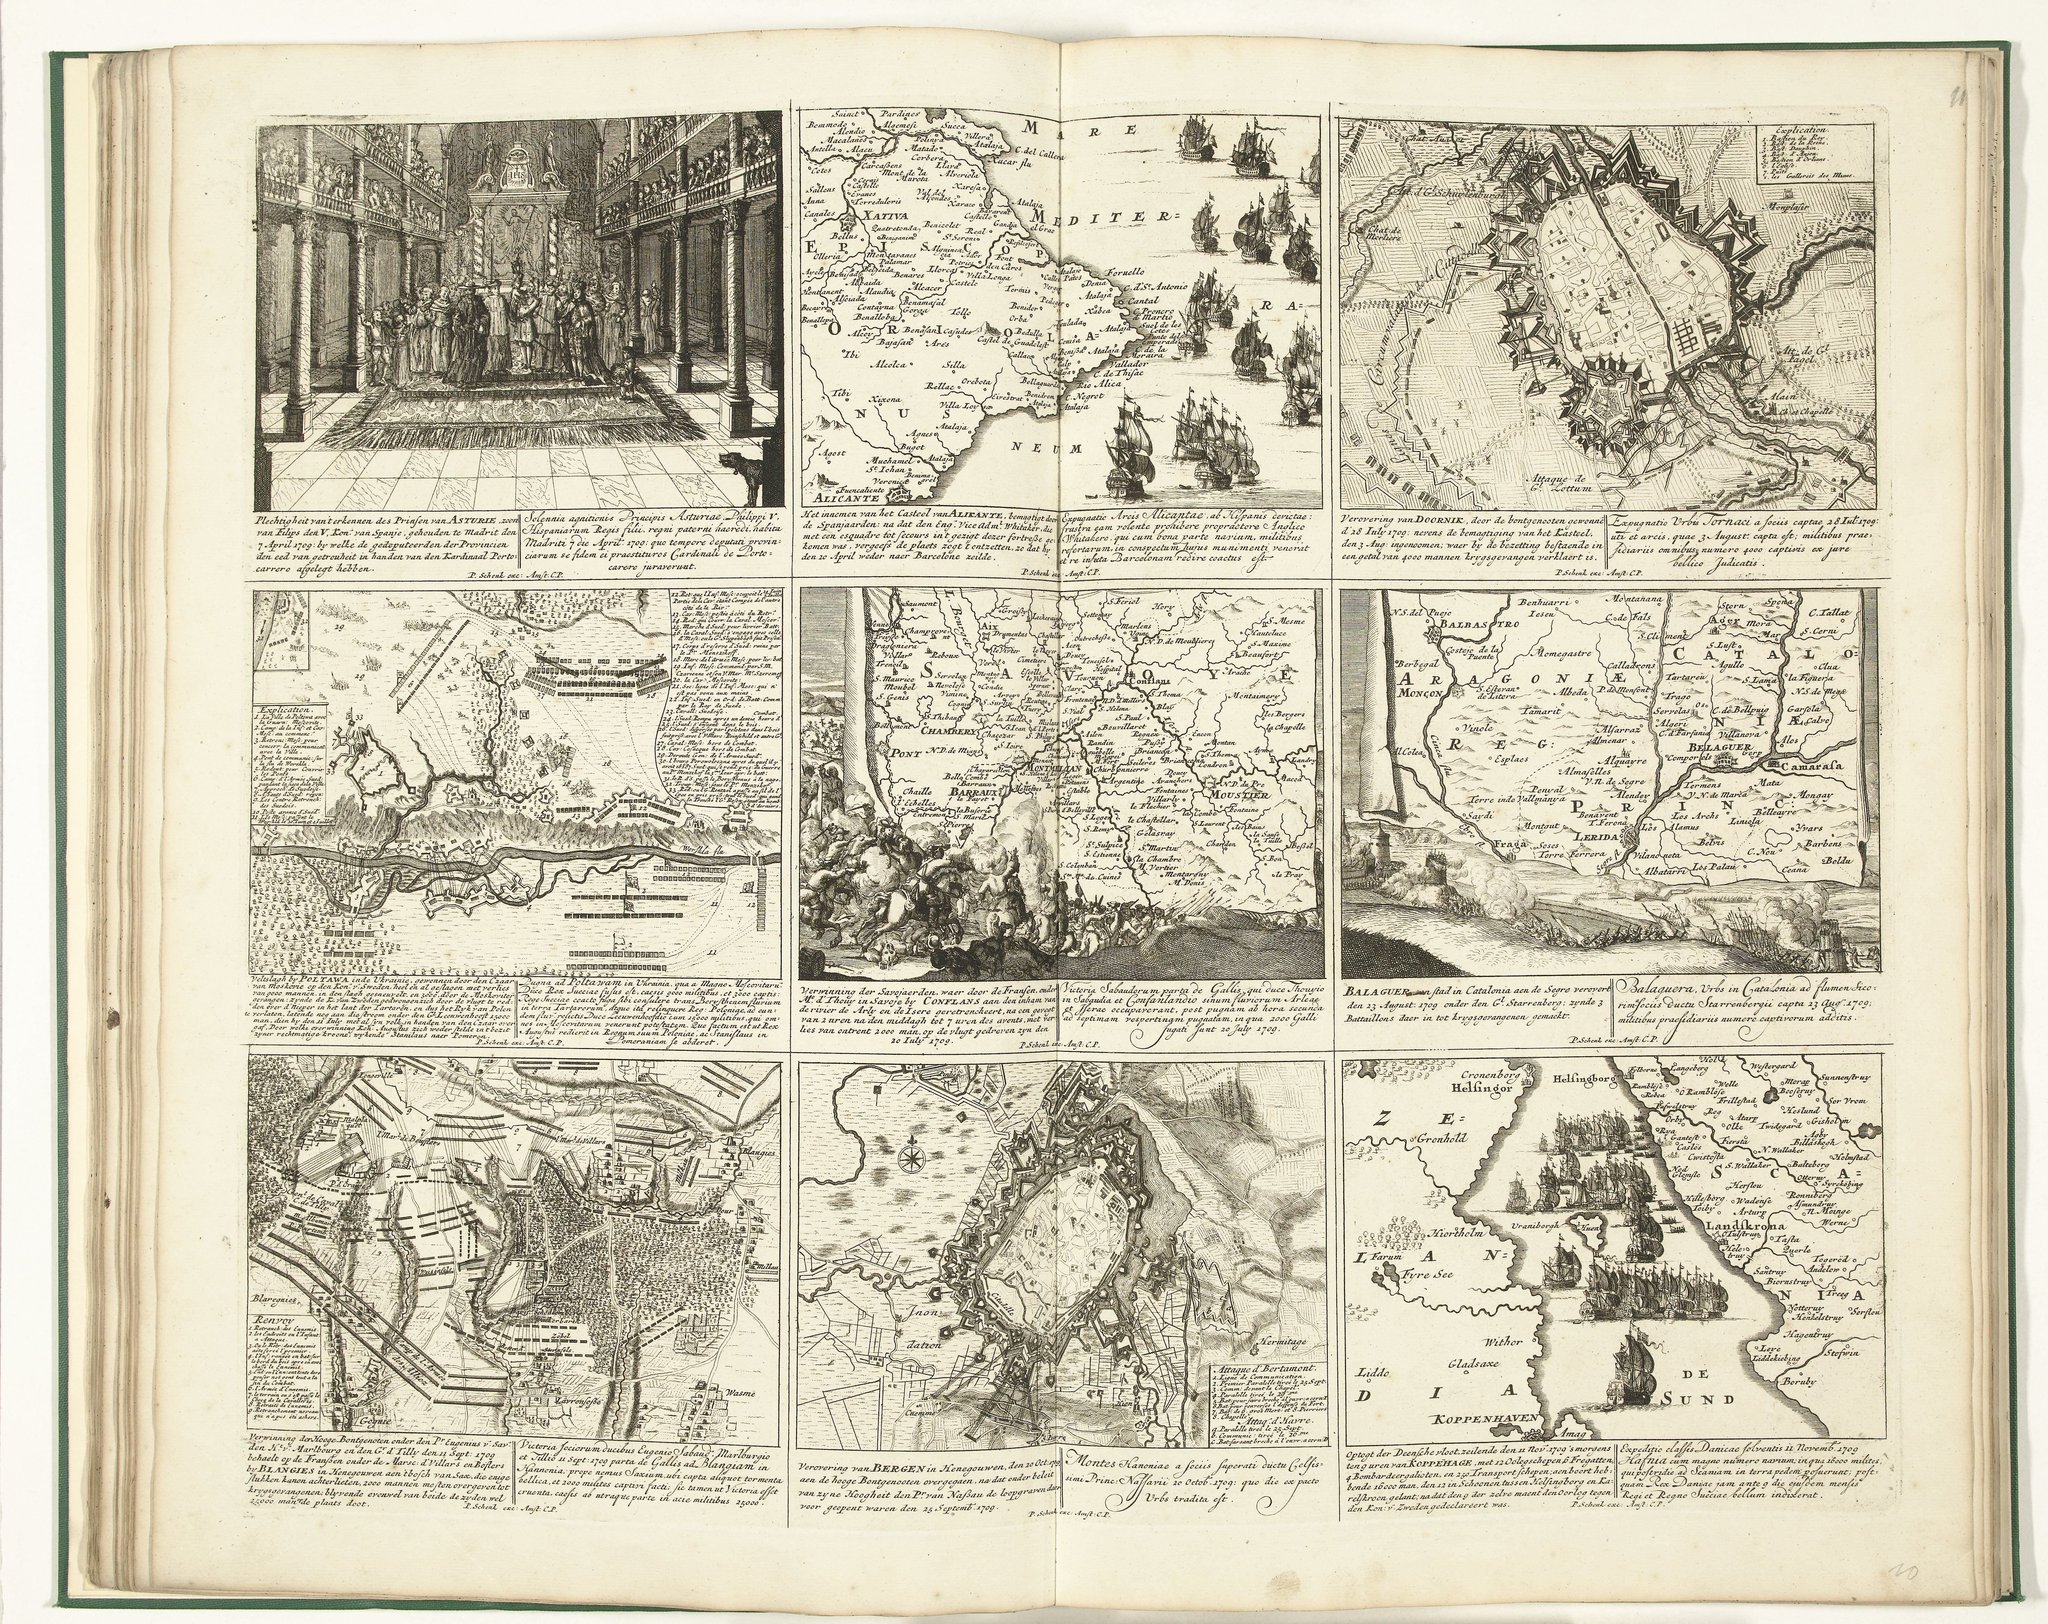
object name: print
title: Schouwburg van den oorlog (blad X), 1709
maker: pieter schenk (i)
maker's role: print maker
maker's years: 1660-1711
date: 1709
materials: paper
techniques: etching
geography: amsterdam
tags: fortress, maps of separate countries or regions, maps of cities, battle (+ land forces), copenhagen (city)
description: Blad met negen voorstellingen van gebeurtenissen uit het jaar 1709 van de Spaanse Successieoorlog en van plattegronden van versterkte steden. Blad X in: Schouwburg van den oorlog (editie van 1720), het prentwerk met de gebundelde reeks van 31 platen over de Spaanse Successieoorlog.